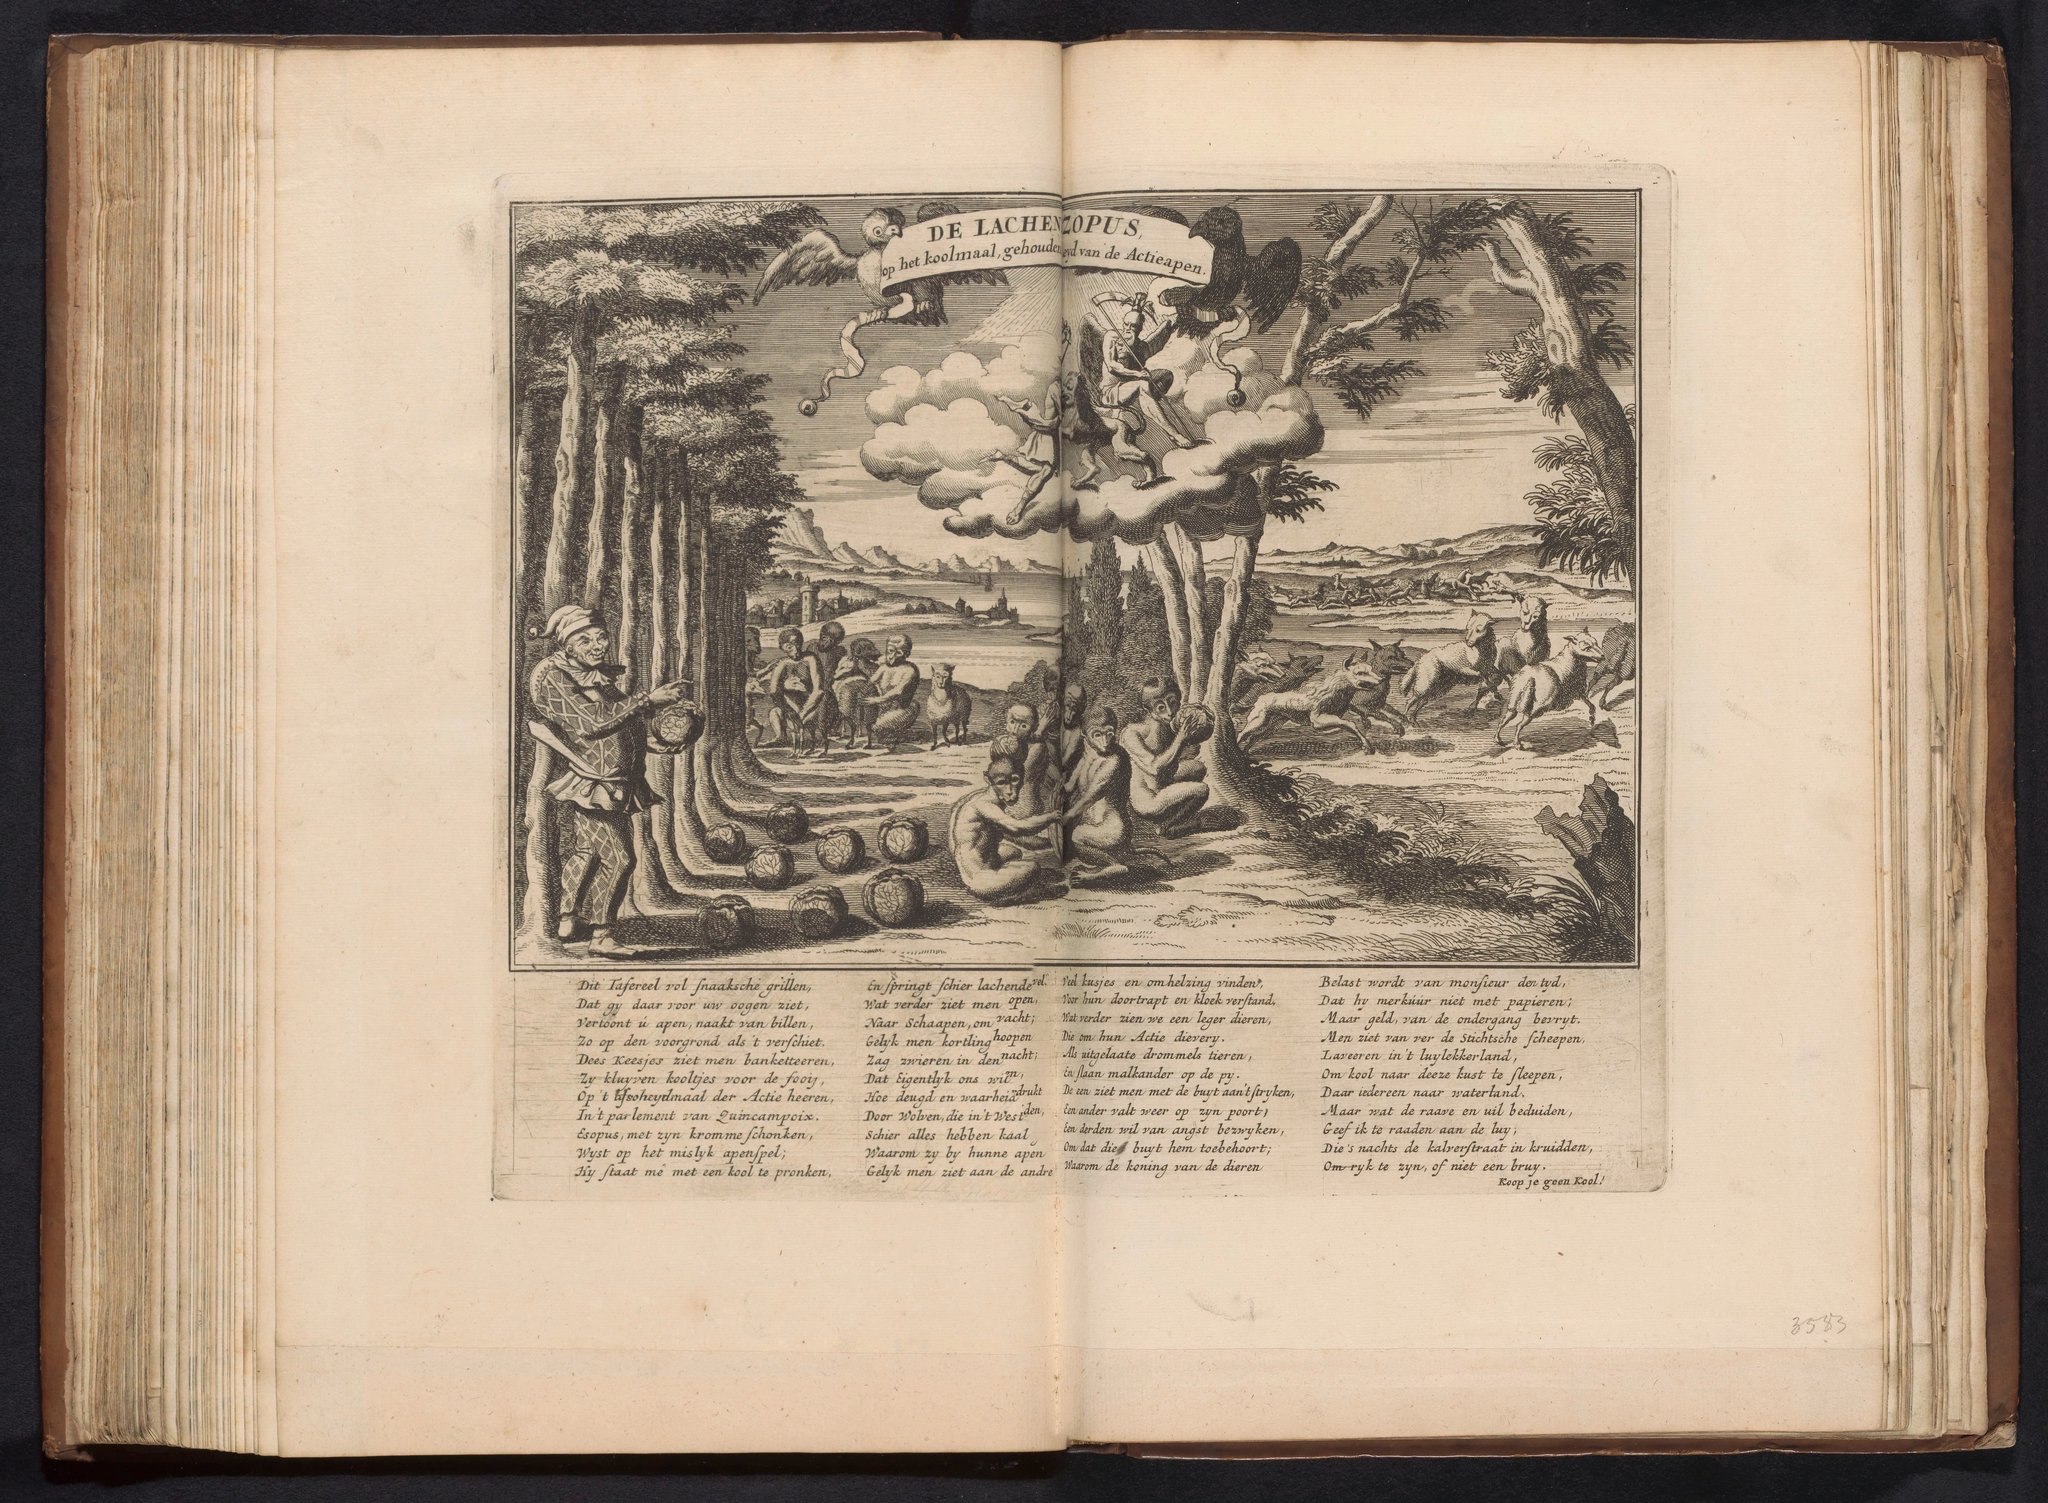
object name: print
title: De lachende Ezopus, op het koolmaal, gehouden ter afscheyd van de Actieapen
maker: Anonymous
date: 1720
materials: paper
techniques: engraving, etching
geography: northern netherlands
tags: monkeys, apes, animals acting as human beings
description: Links staat de lachende Aesopus, Bombario in harlekijnspak, bij een groep apen die kool eten (de slachtoffers van de windhandel). Rechts jagen wolven op schapen. In de wolken Mercurius, de Nederlandse Leeuw en Vader Tijd. In het onderschrift een vers in vier kolommen. Prent in de gebonden eerste uitgave (304 B 11) van Het Groote Tafereel der Dwaasheid met spotprenten op de Windhandel of Actiehandel van 1720.